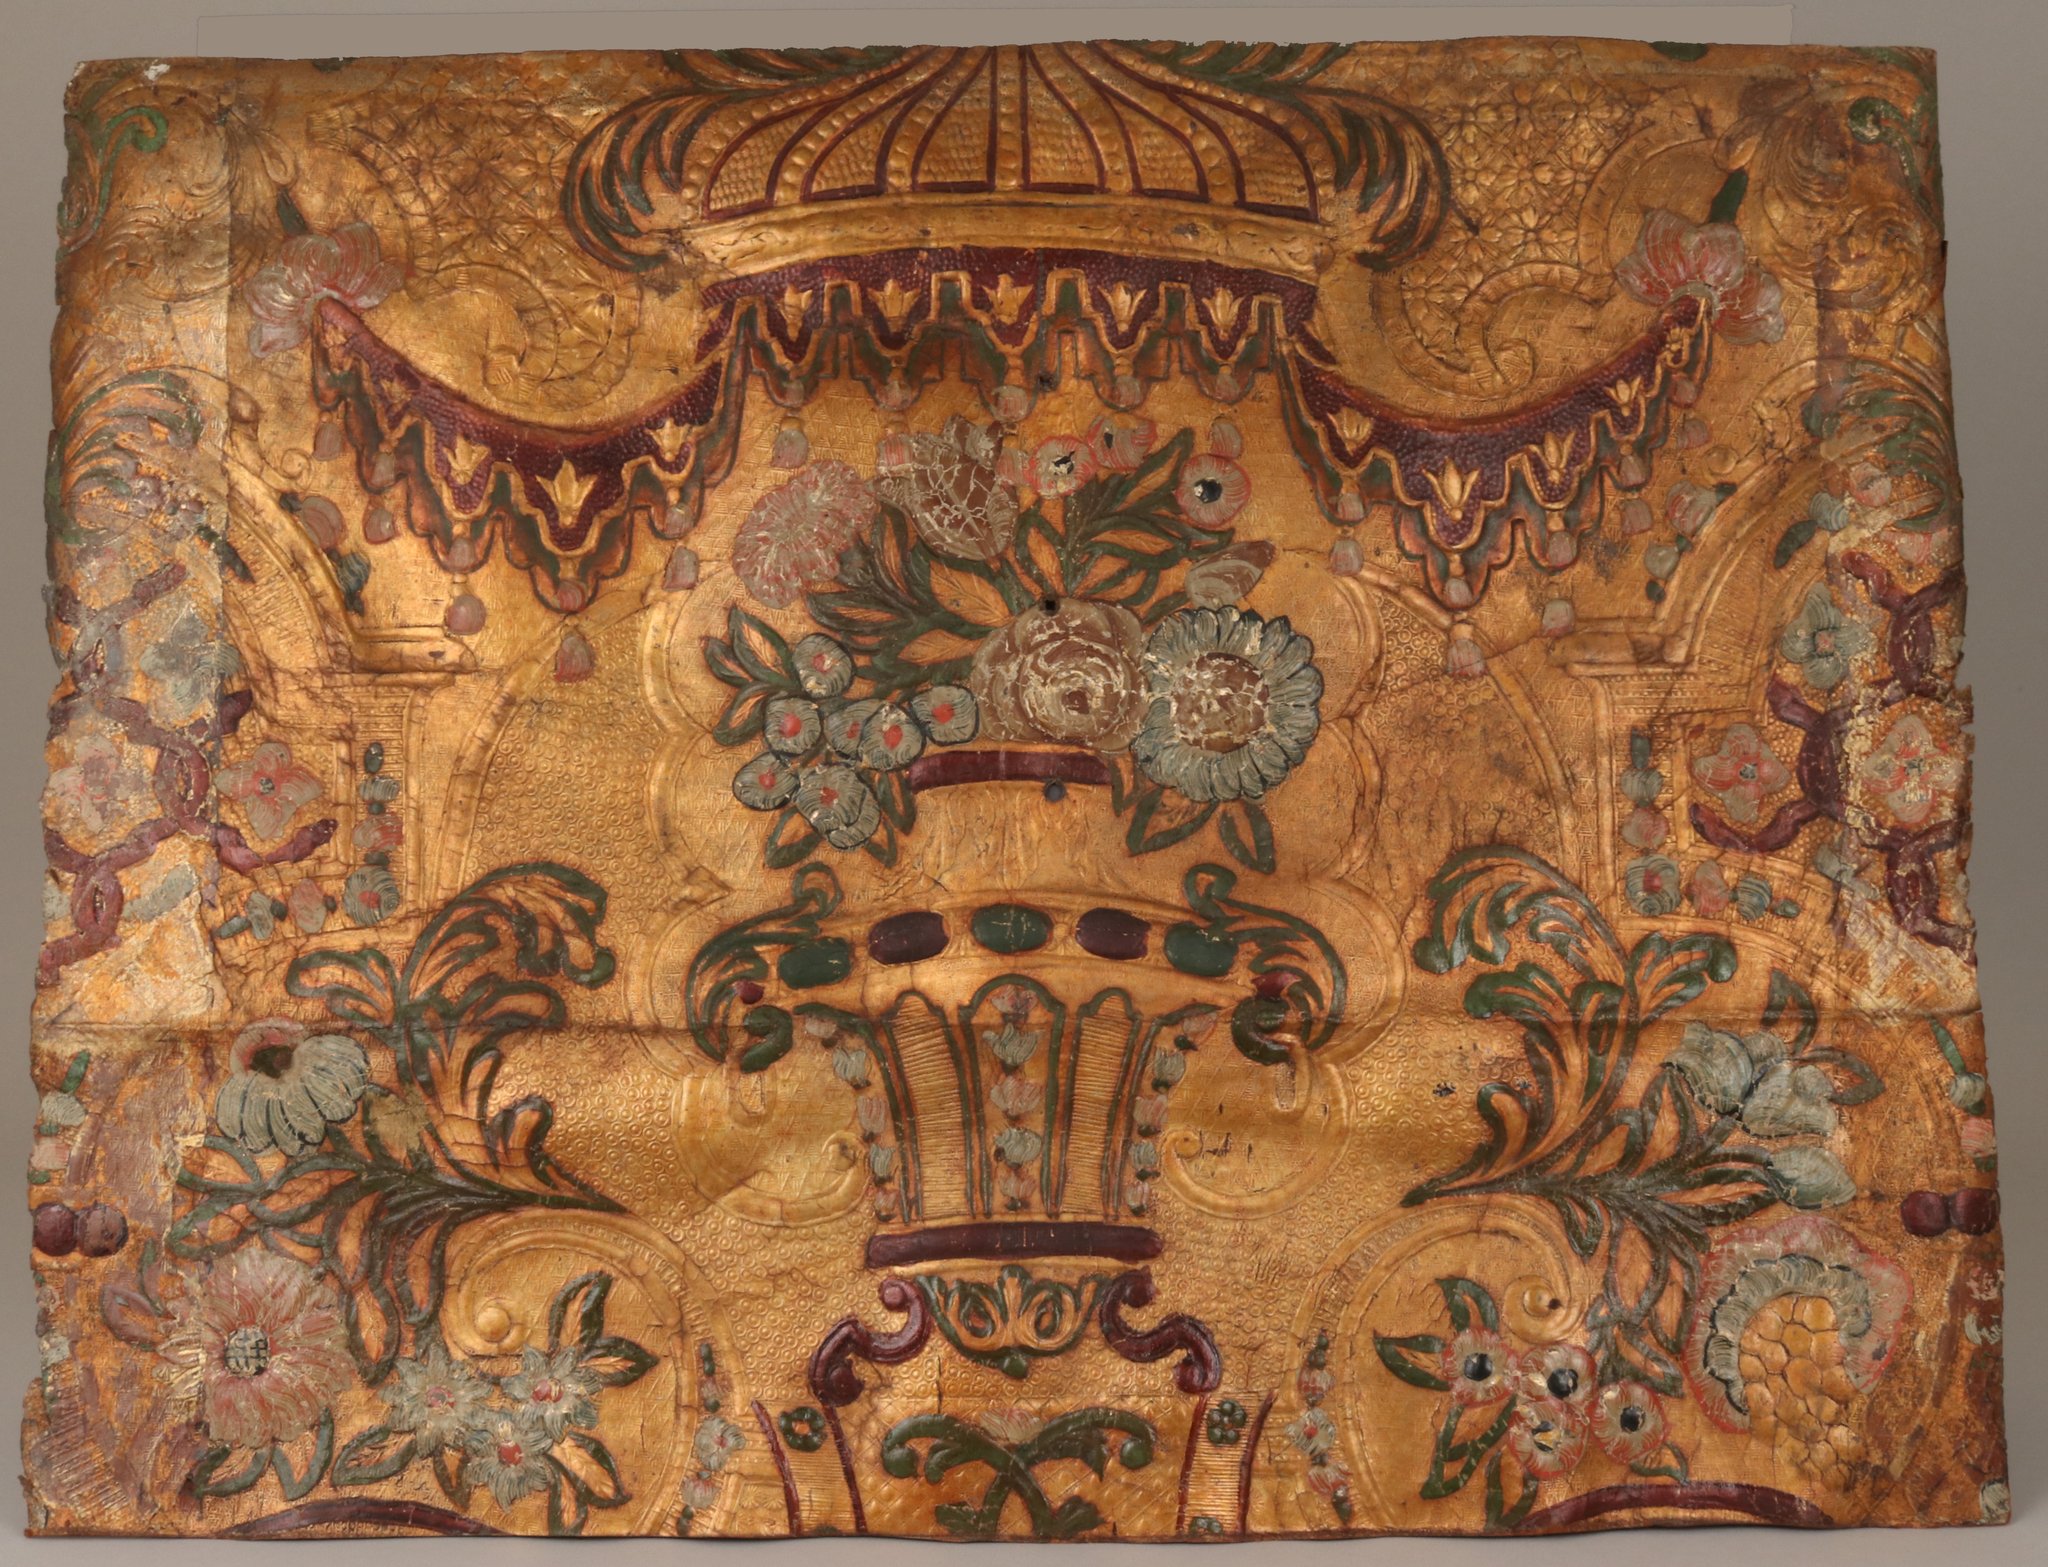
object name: wall hanging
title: Wall hanging fragment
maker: daniel marot the elder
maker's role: artist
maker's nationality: french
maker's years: 1661-1752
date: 1701-1725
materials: leather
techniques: embossing, gilding, polychrome